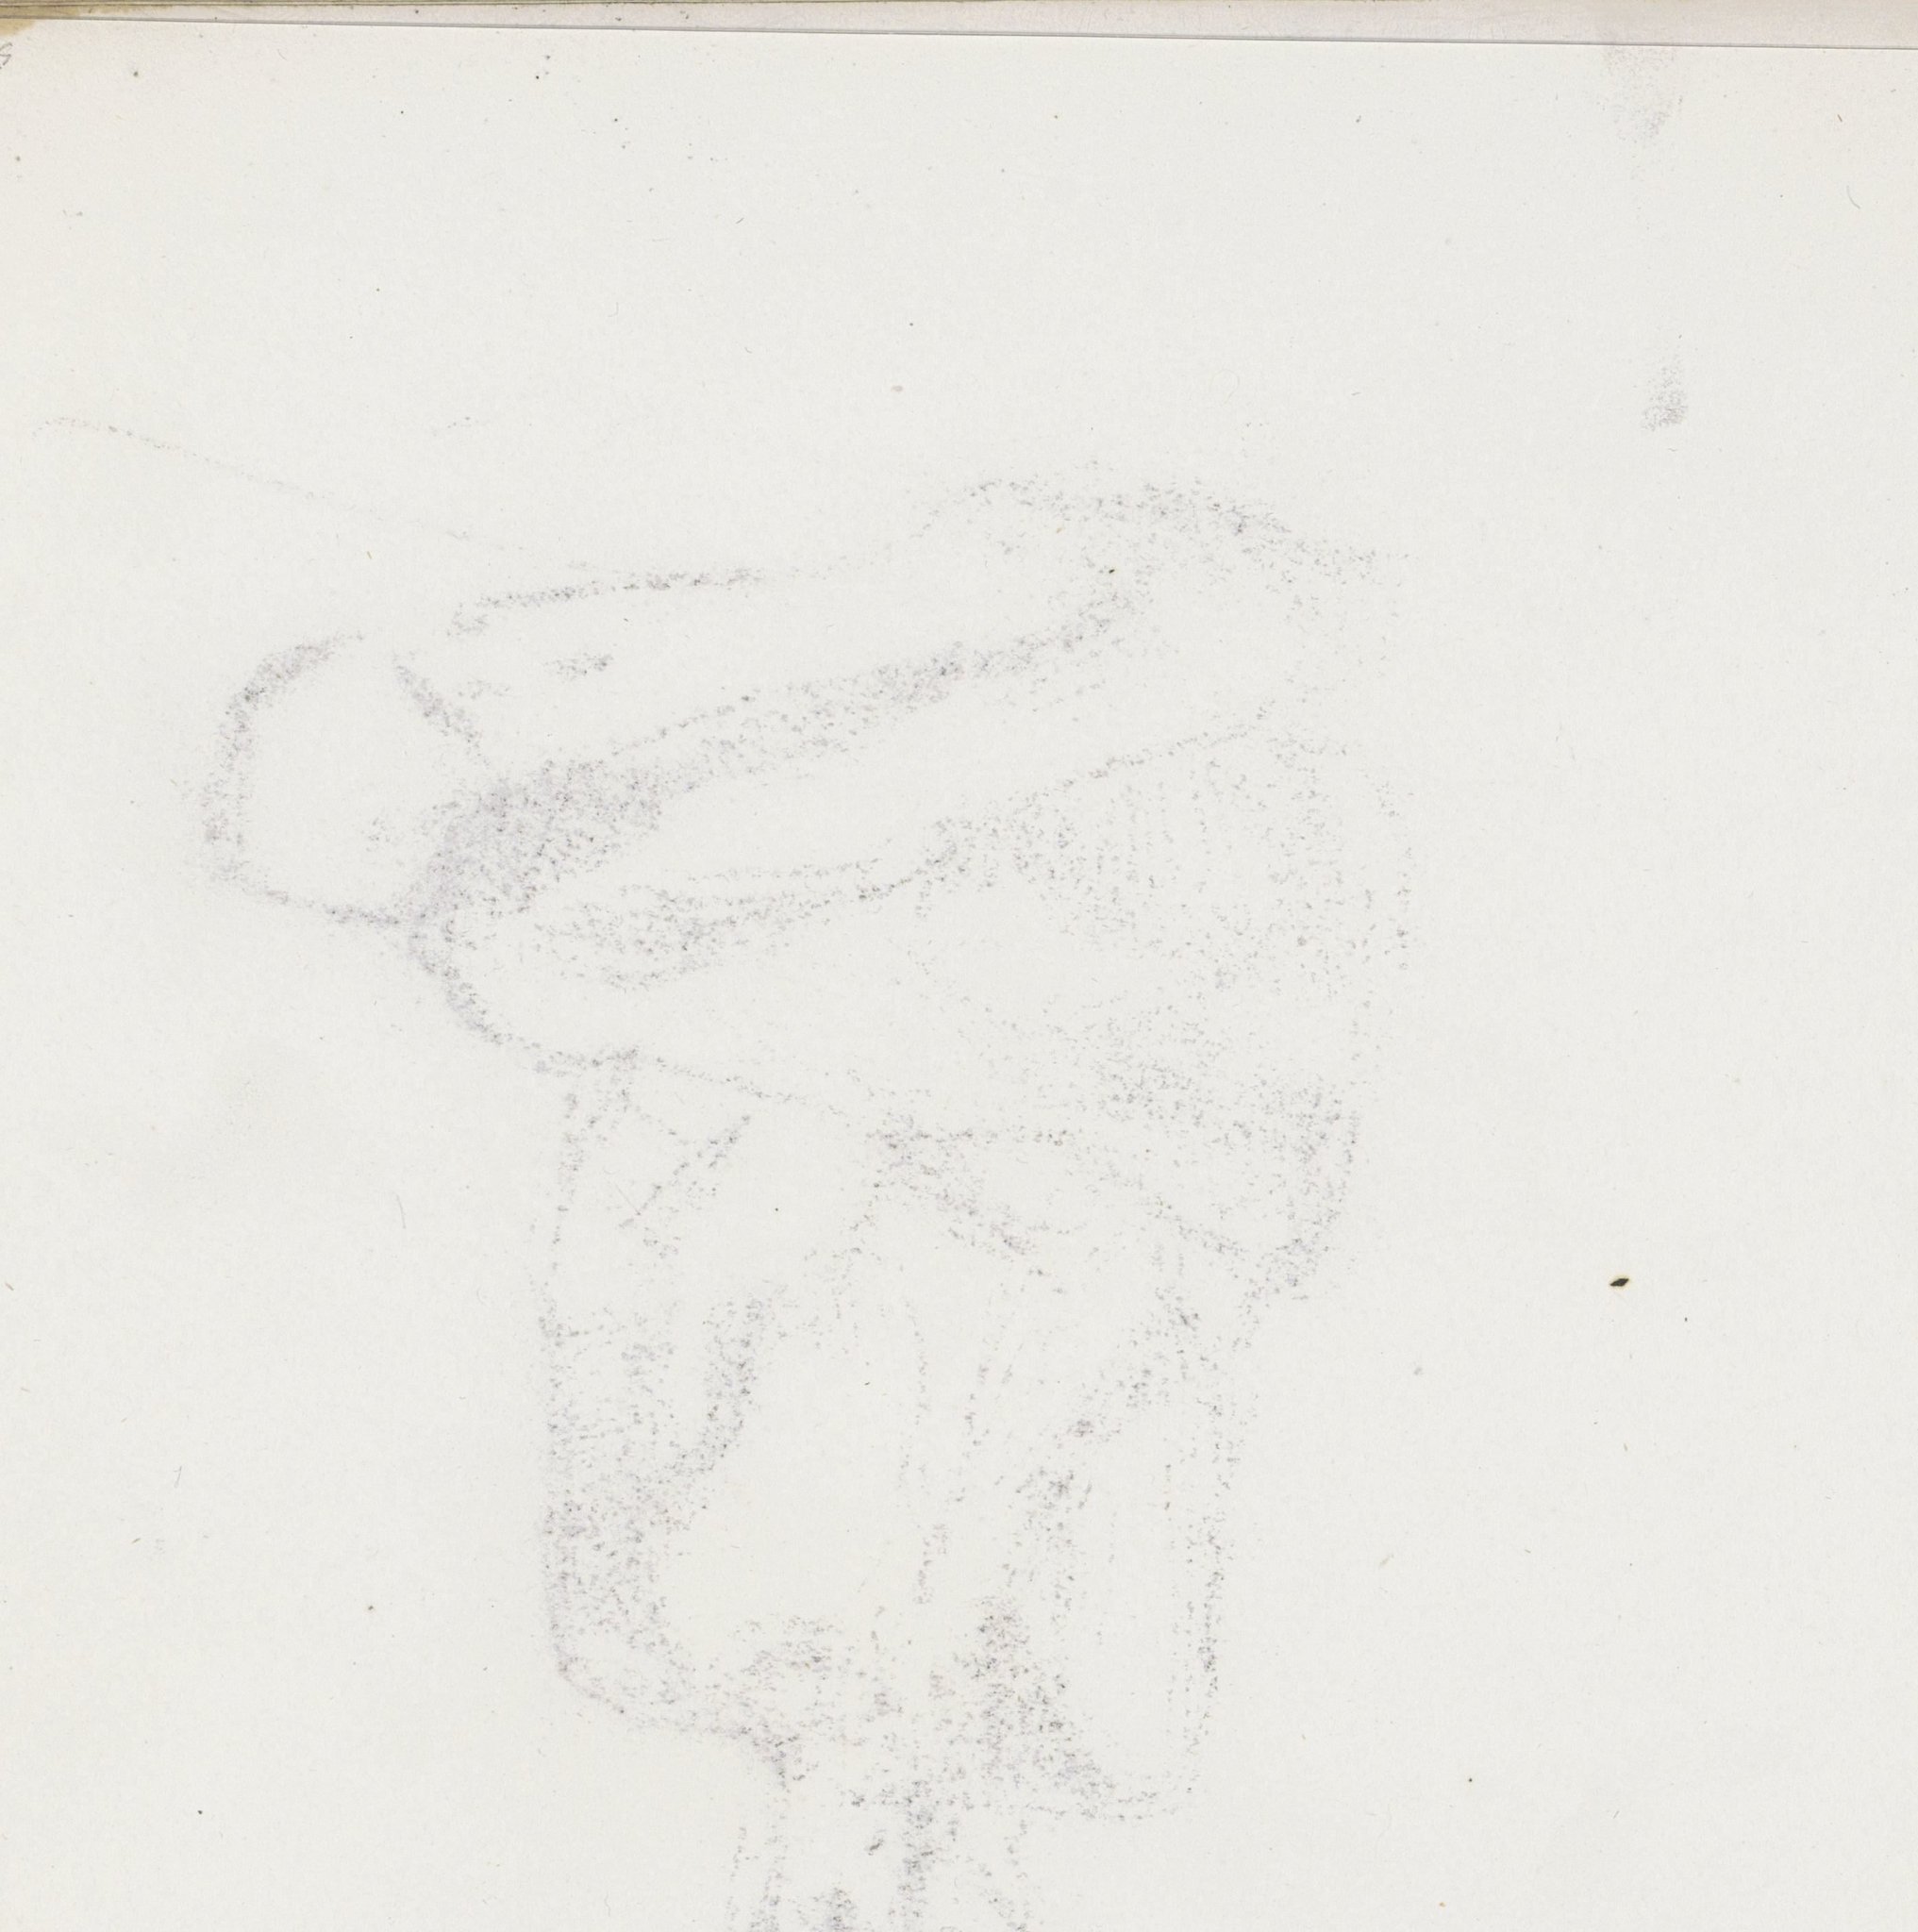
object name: sketchbook leaf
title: Abklatsch van de krijttekening op blad 4 recto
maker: isaac israels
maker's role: draughtsman, painter, print maker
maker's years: 1865-1934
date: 1875-1934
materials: paper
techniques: printmaking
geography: the hague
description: Blad 3 verso uit schetsboek IX met 28 bladen.